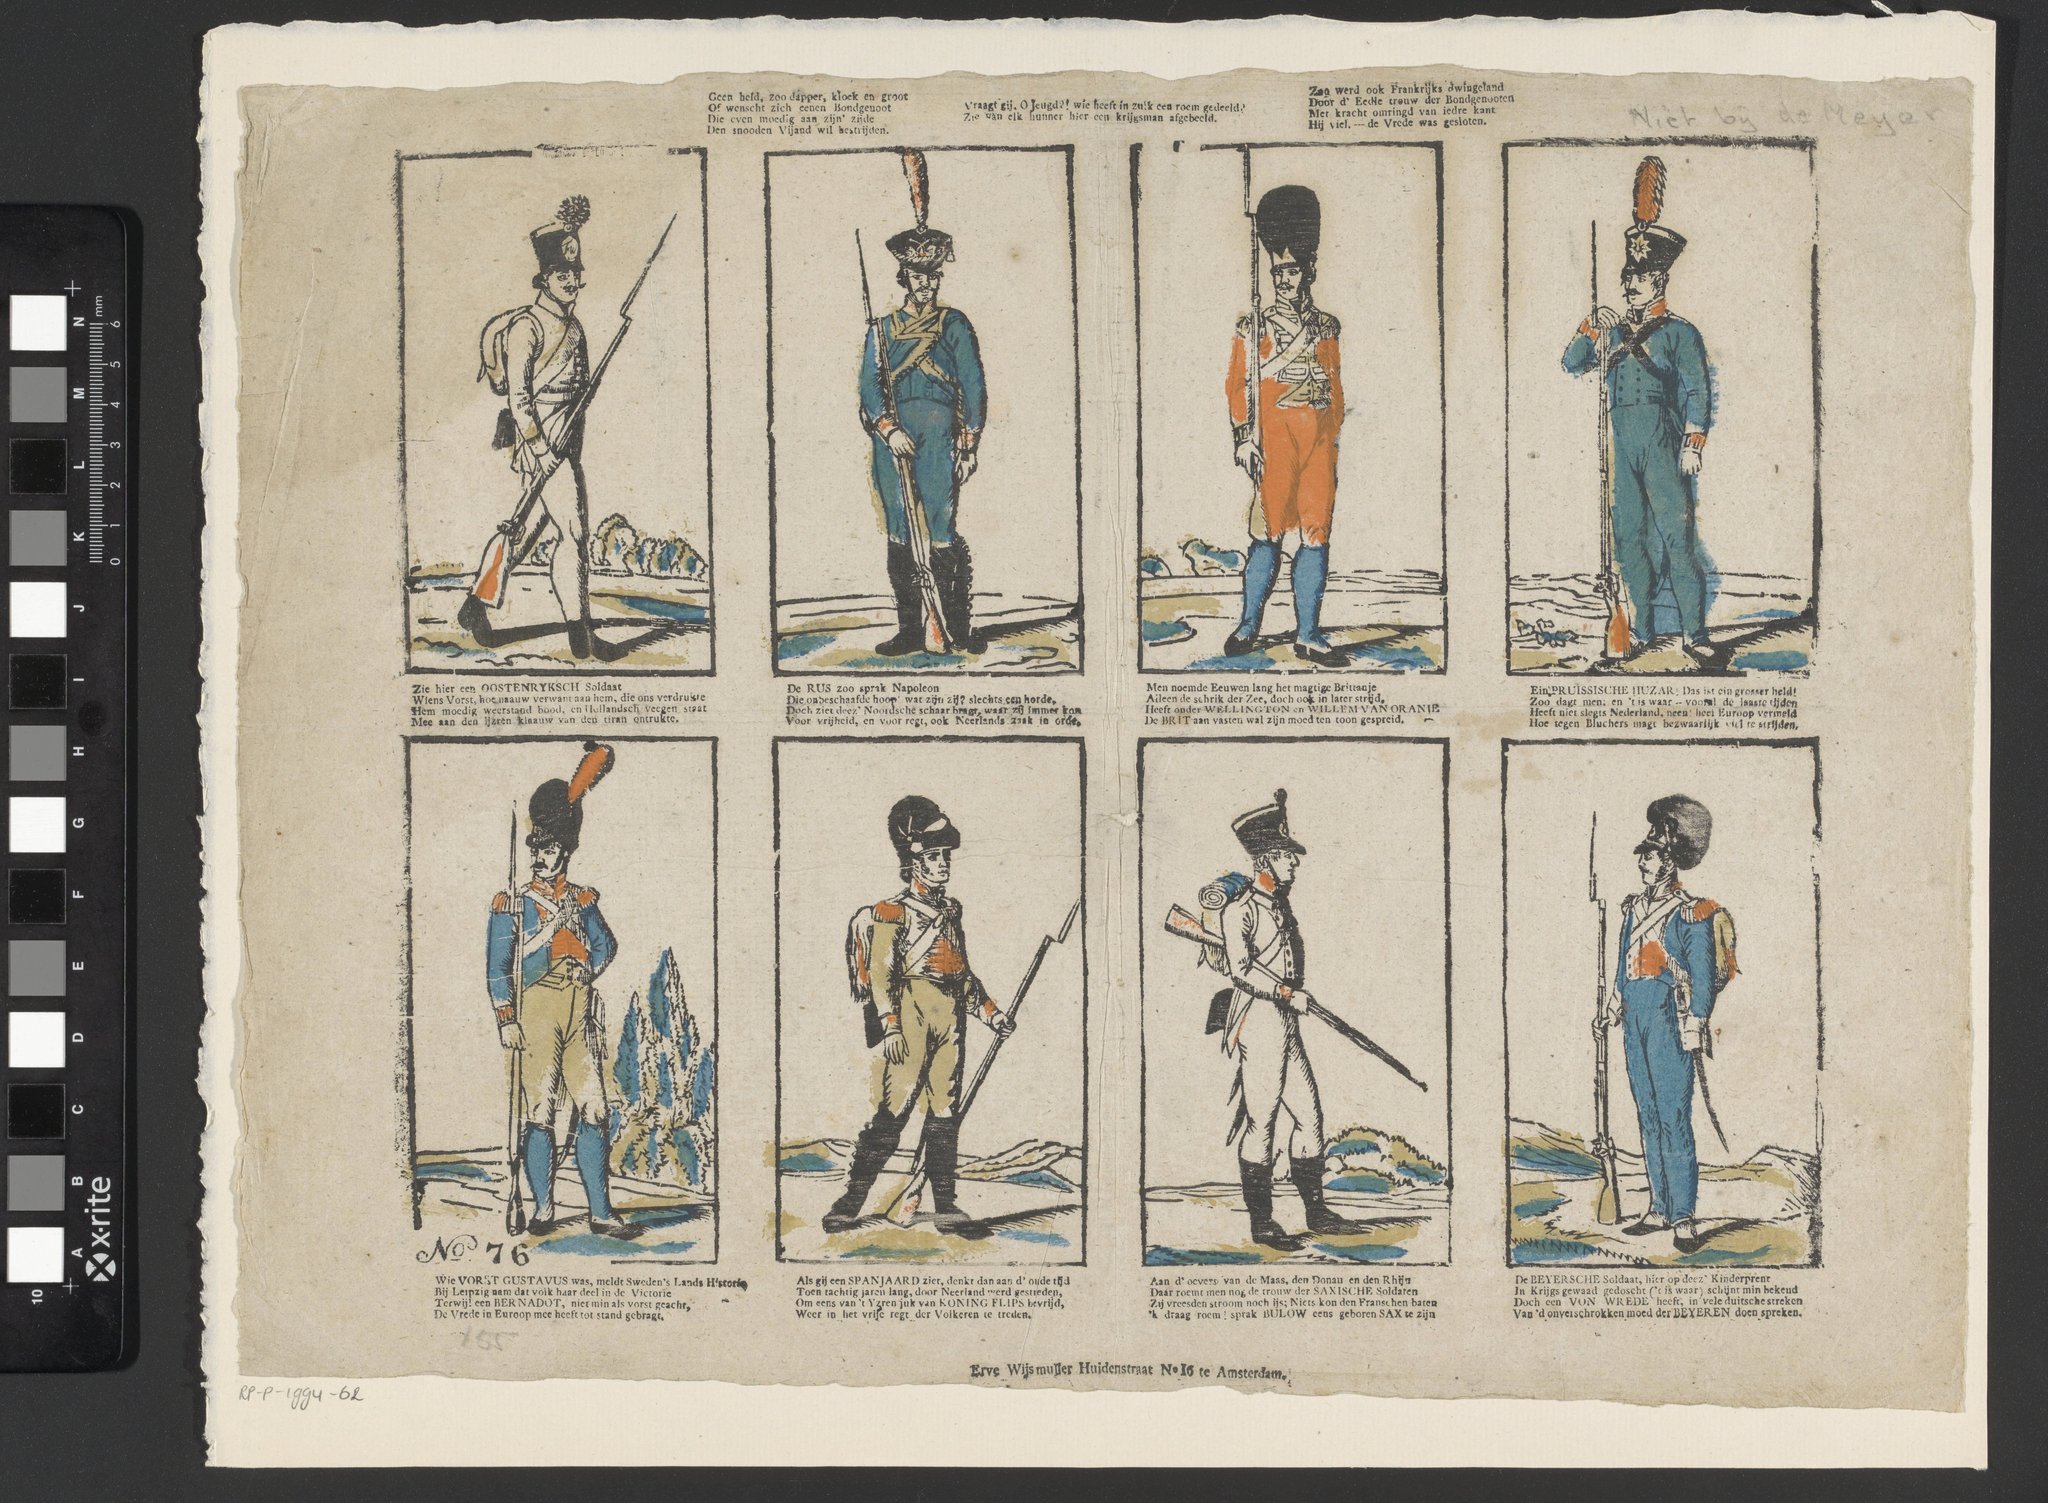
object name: popular print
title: Geen held, zoo dapper, kloek en groot / Of wenscht zich eenen bondgenoot (...)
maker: Anonymous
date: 1828-1913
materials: paper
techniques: colour, letterpress printing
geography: netherlands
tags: the soldier; the soldier's life, (military) uniforms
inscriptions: collector's mark: Lugt 2760, collector's mark: Lugt 2228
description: Blad met 8 voorstellingen van militairen van verschillende nationaliteiten. Onder elke afbeelding een vierregelig vers. Genummerd linksonder: No. 76.